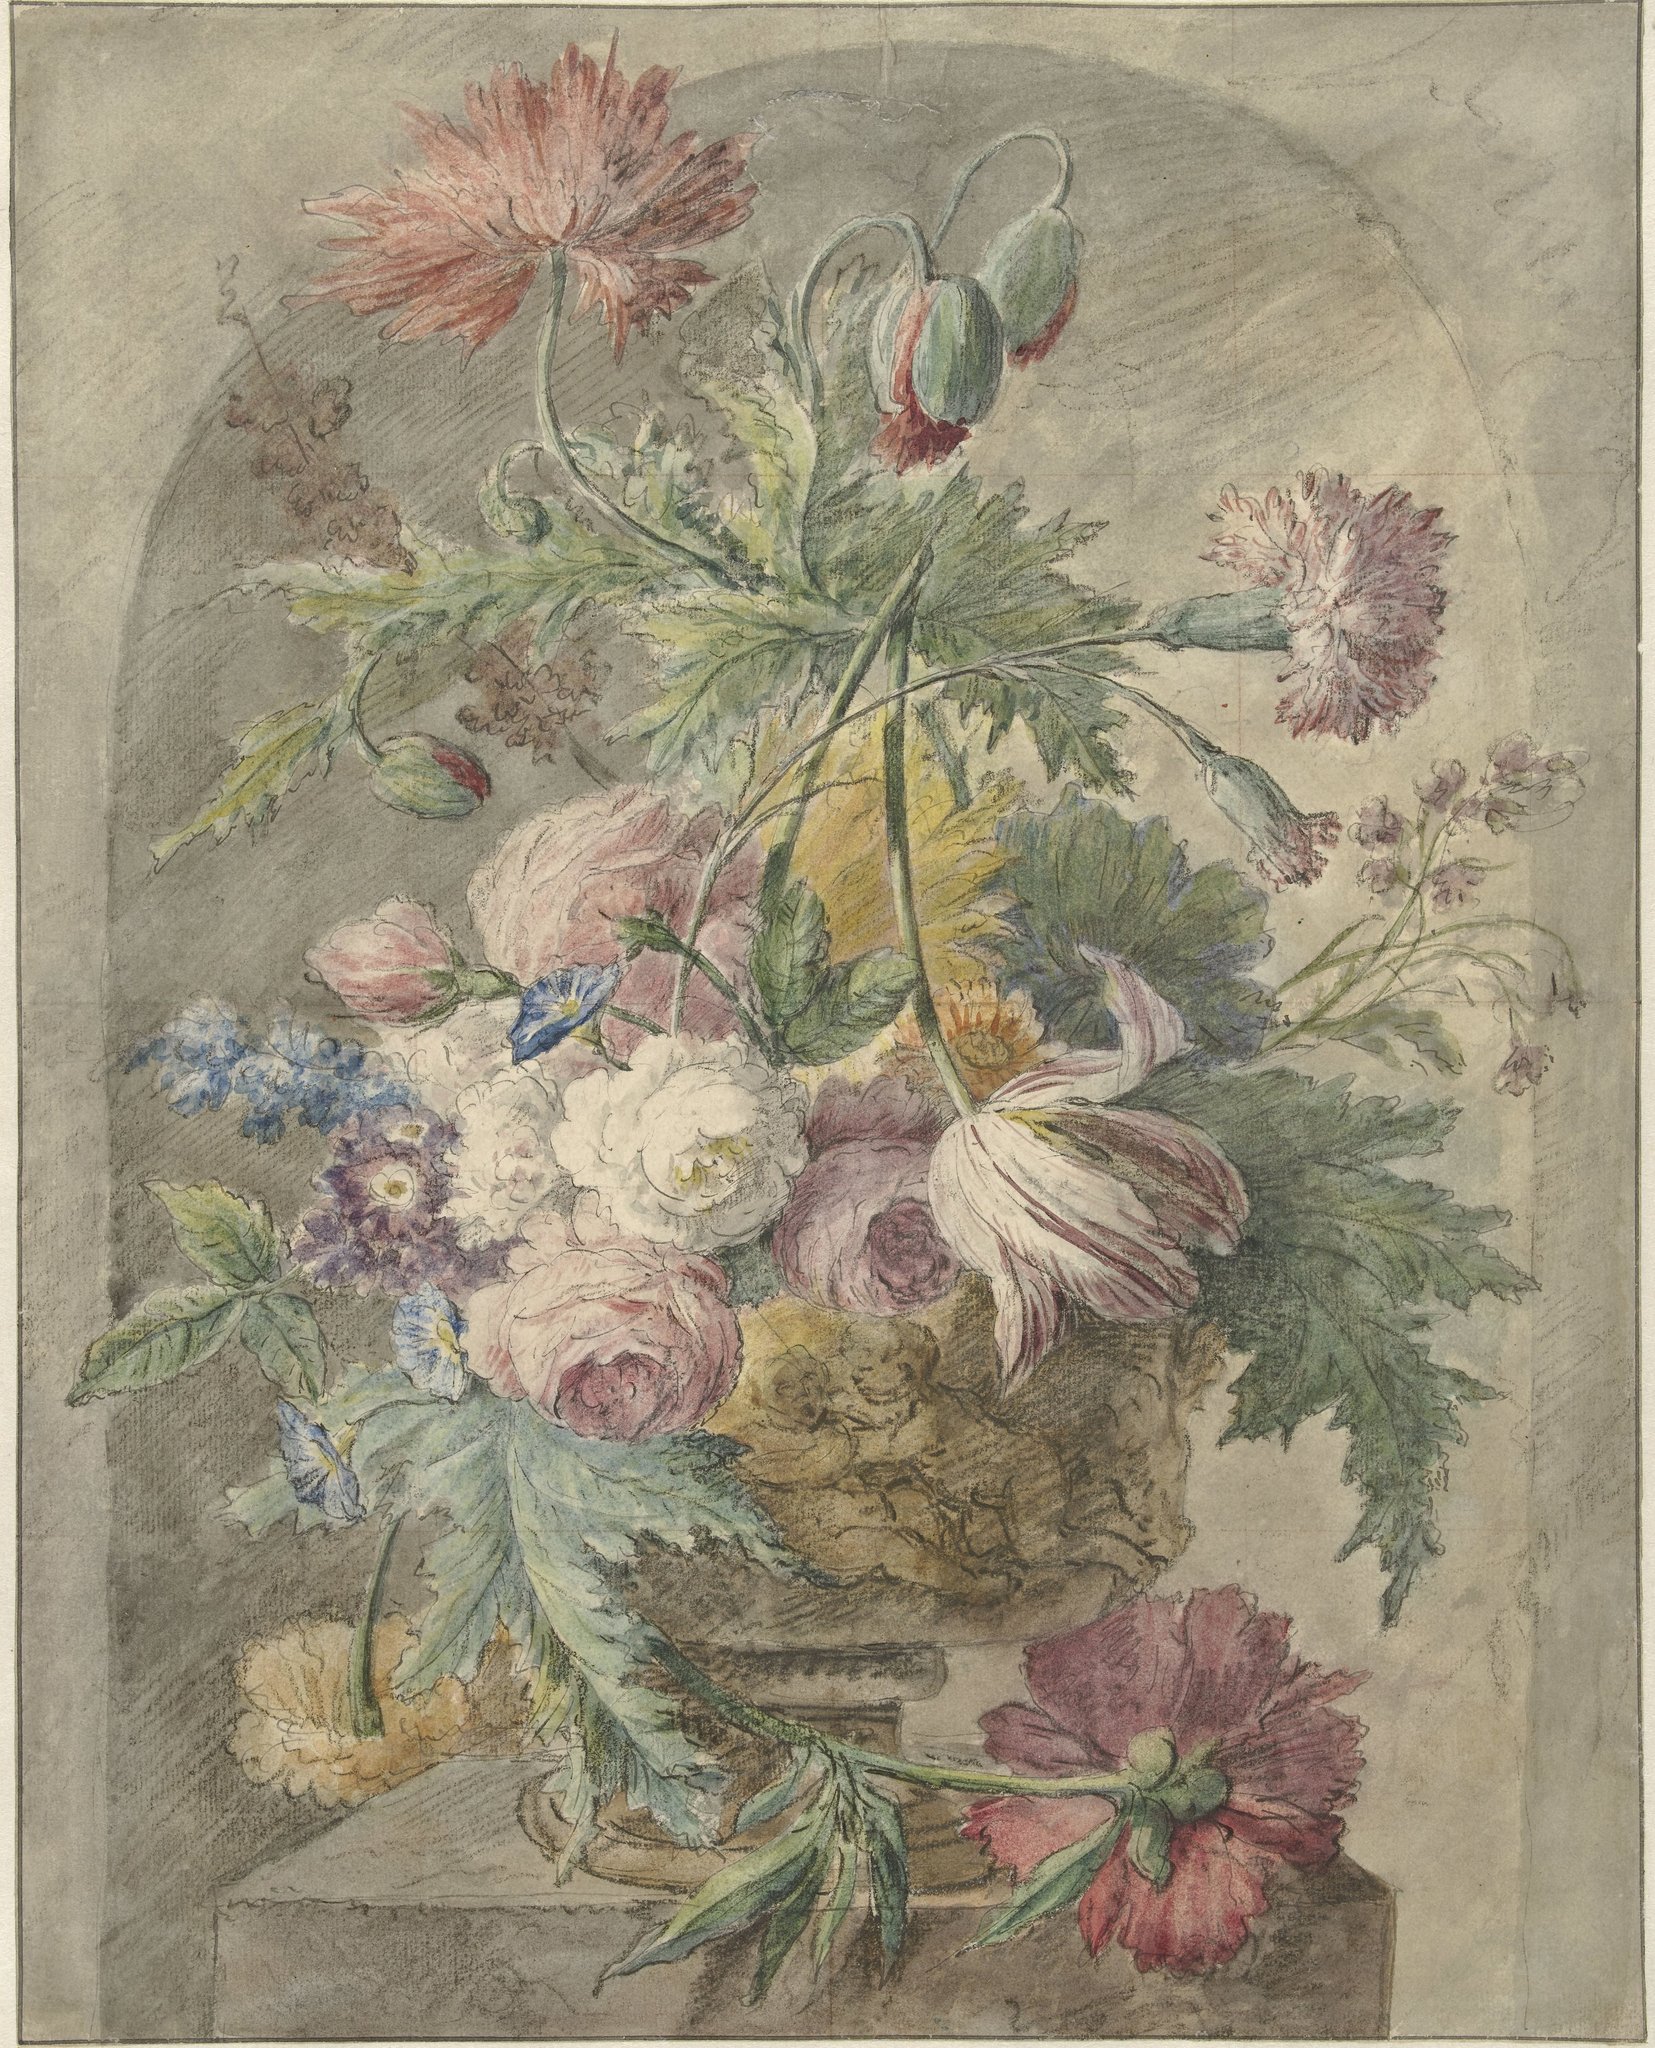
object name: drawing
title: Bloemen in een vaas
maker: Anonymous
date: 1700-1800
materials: chalk, ink, paper, watercolor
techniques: brush, pen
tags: flowers in a vase